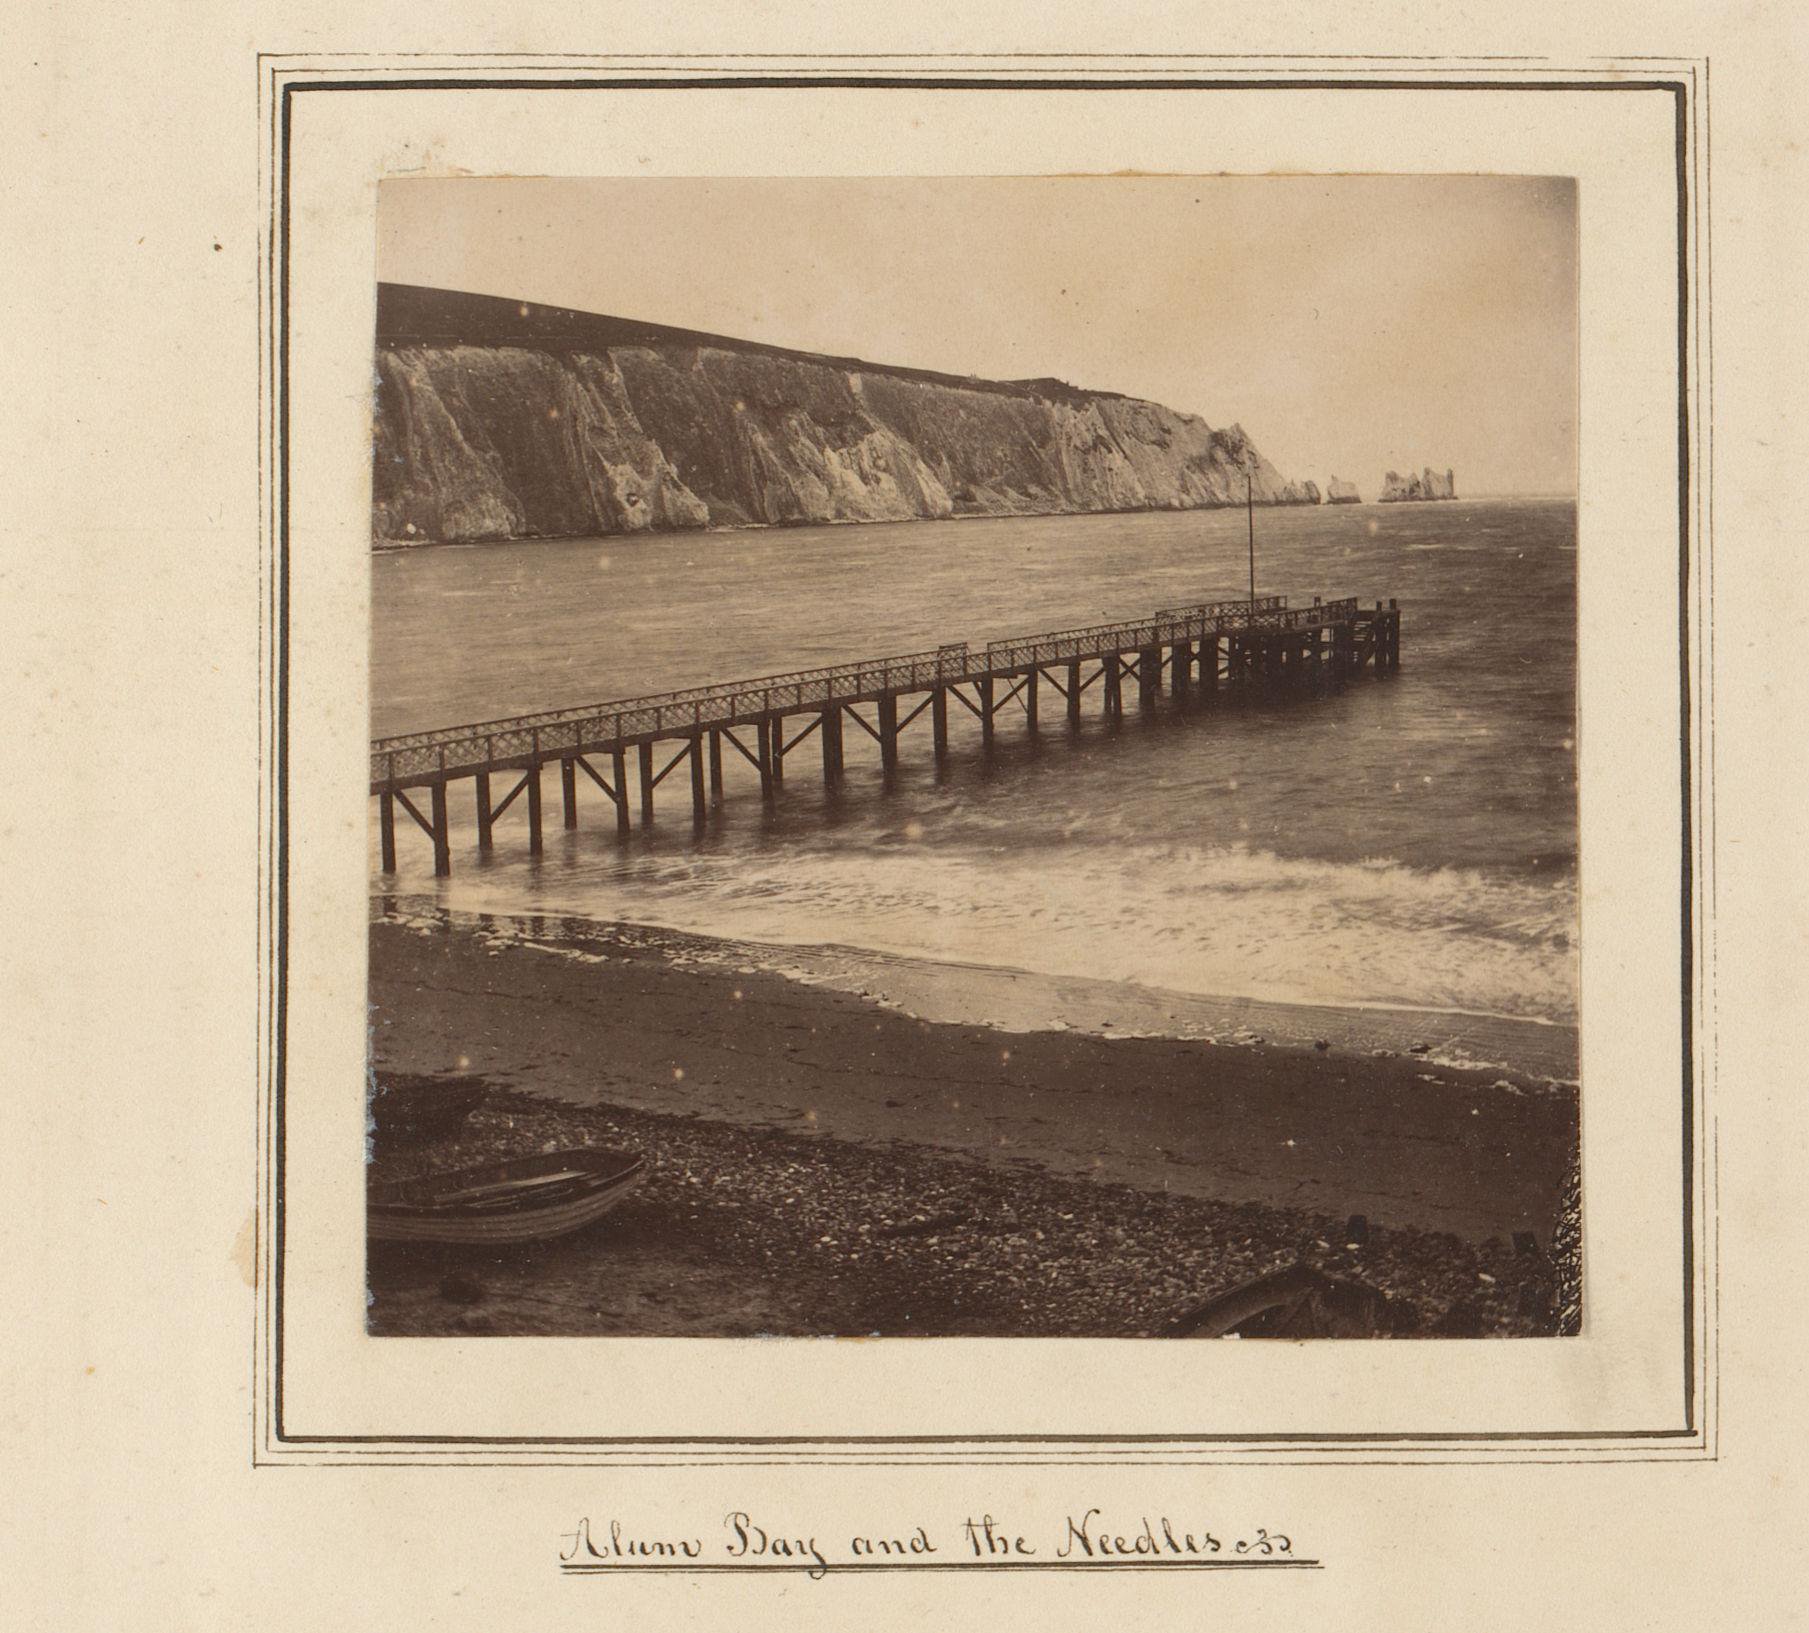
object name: photograph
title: Pier bij Alum Bay, met op de achtergrond the Needles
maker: Anonymous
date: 1870-1890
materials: paper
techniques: albumen print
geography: alum bay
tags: pier, quay, wharf, coastal cliff or crag